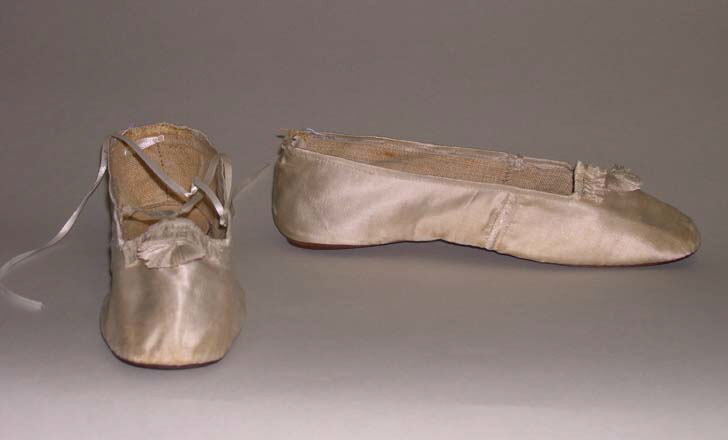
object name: slipper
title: Slippers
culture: american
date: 1810-1819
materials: leather